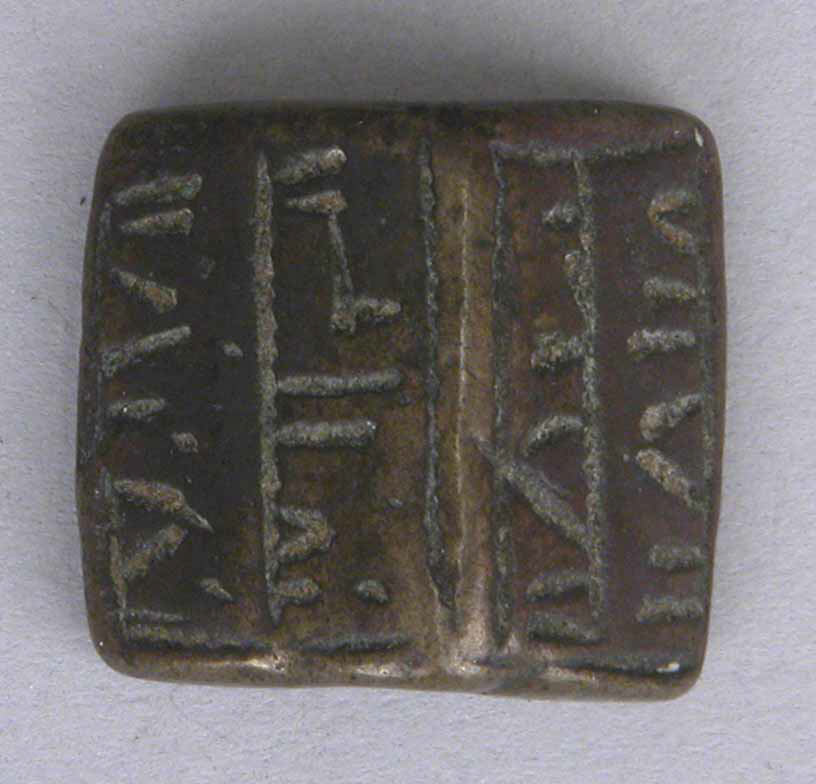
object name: bead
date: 901-1400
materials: bronze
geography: iraq